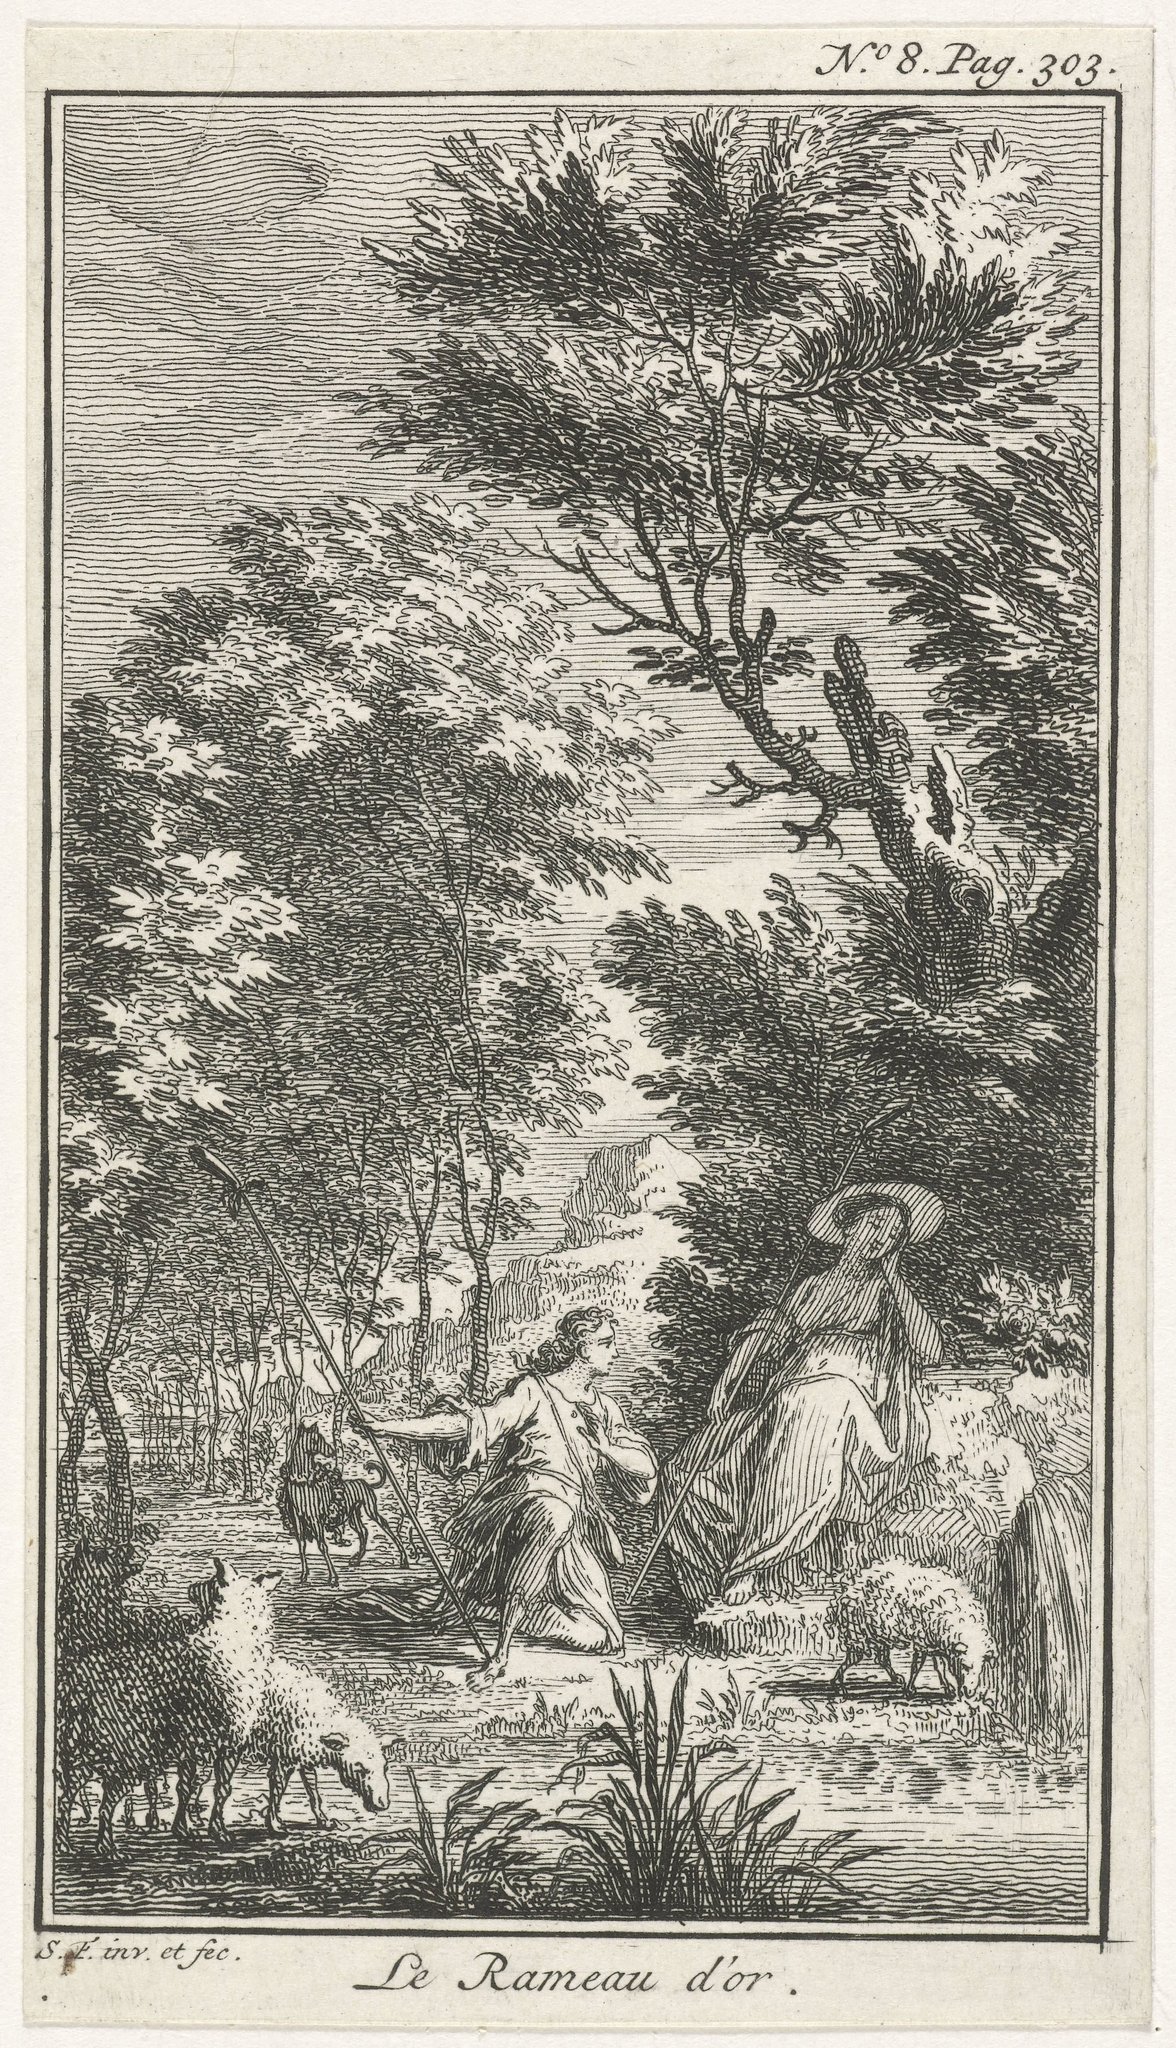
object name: print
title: Schaapherder knielt voor herderin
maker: simon fokke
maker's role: draughtsman, print maker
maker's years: 1712-1784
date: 1722-1784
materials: paper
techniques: etching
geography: amsterdam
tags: herding, herdsman, herdswoman, shepherd, shepherdess, cowherd, etc., kneeling figure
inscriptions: collector's mark: Lugt 240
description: Illustratie uit het sprookje Le Rameau d’or van Mme d'Aulnoy. Een schaapherder knielt voor een herderin die op een steen aan het rusten is. Op de voorgrond loopt een aantal schapen. Prent rechtsboven gemerkt: No. 8. Pag. 303.